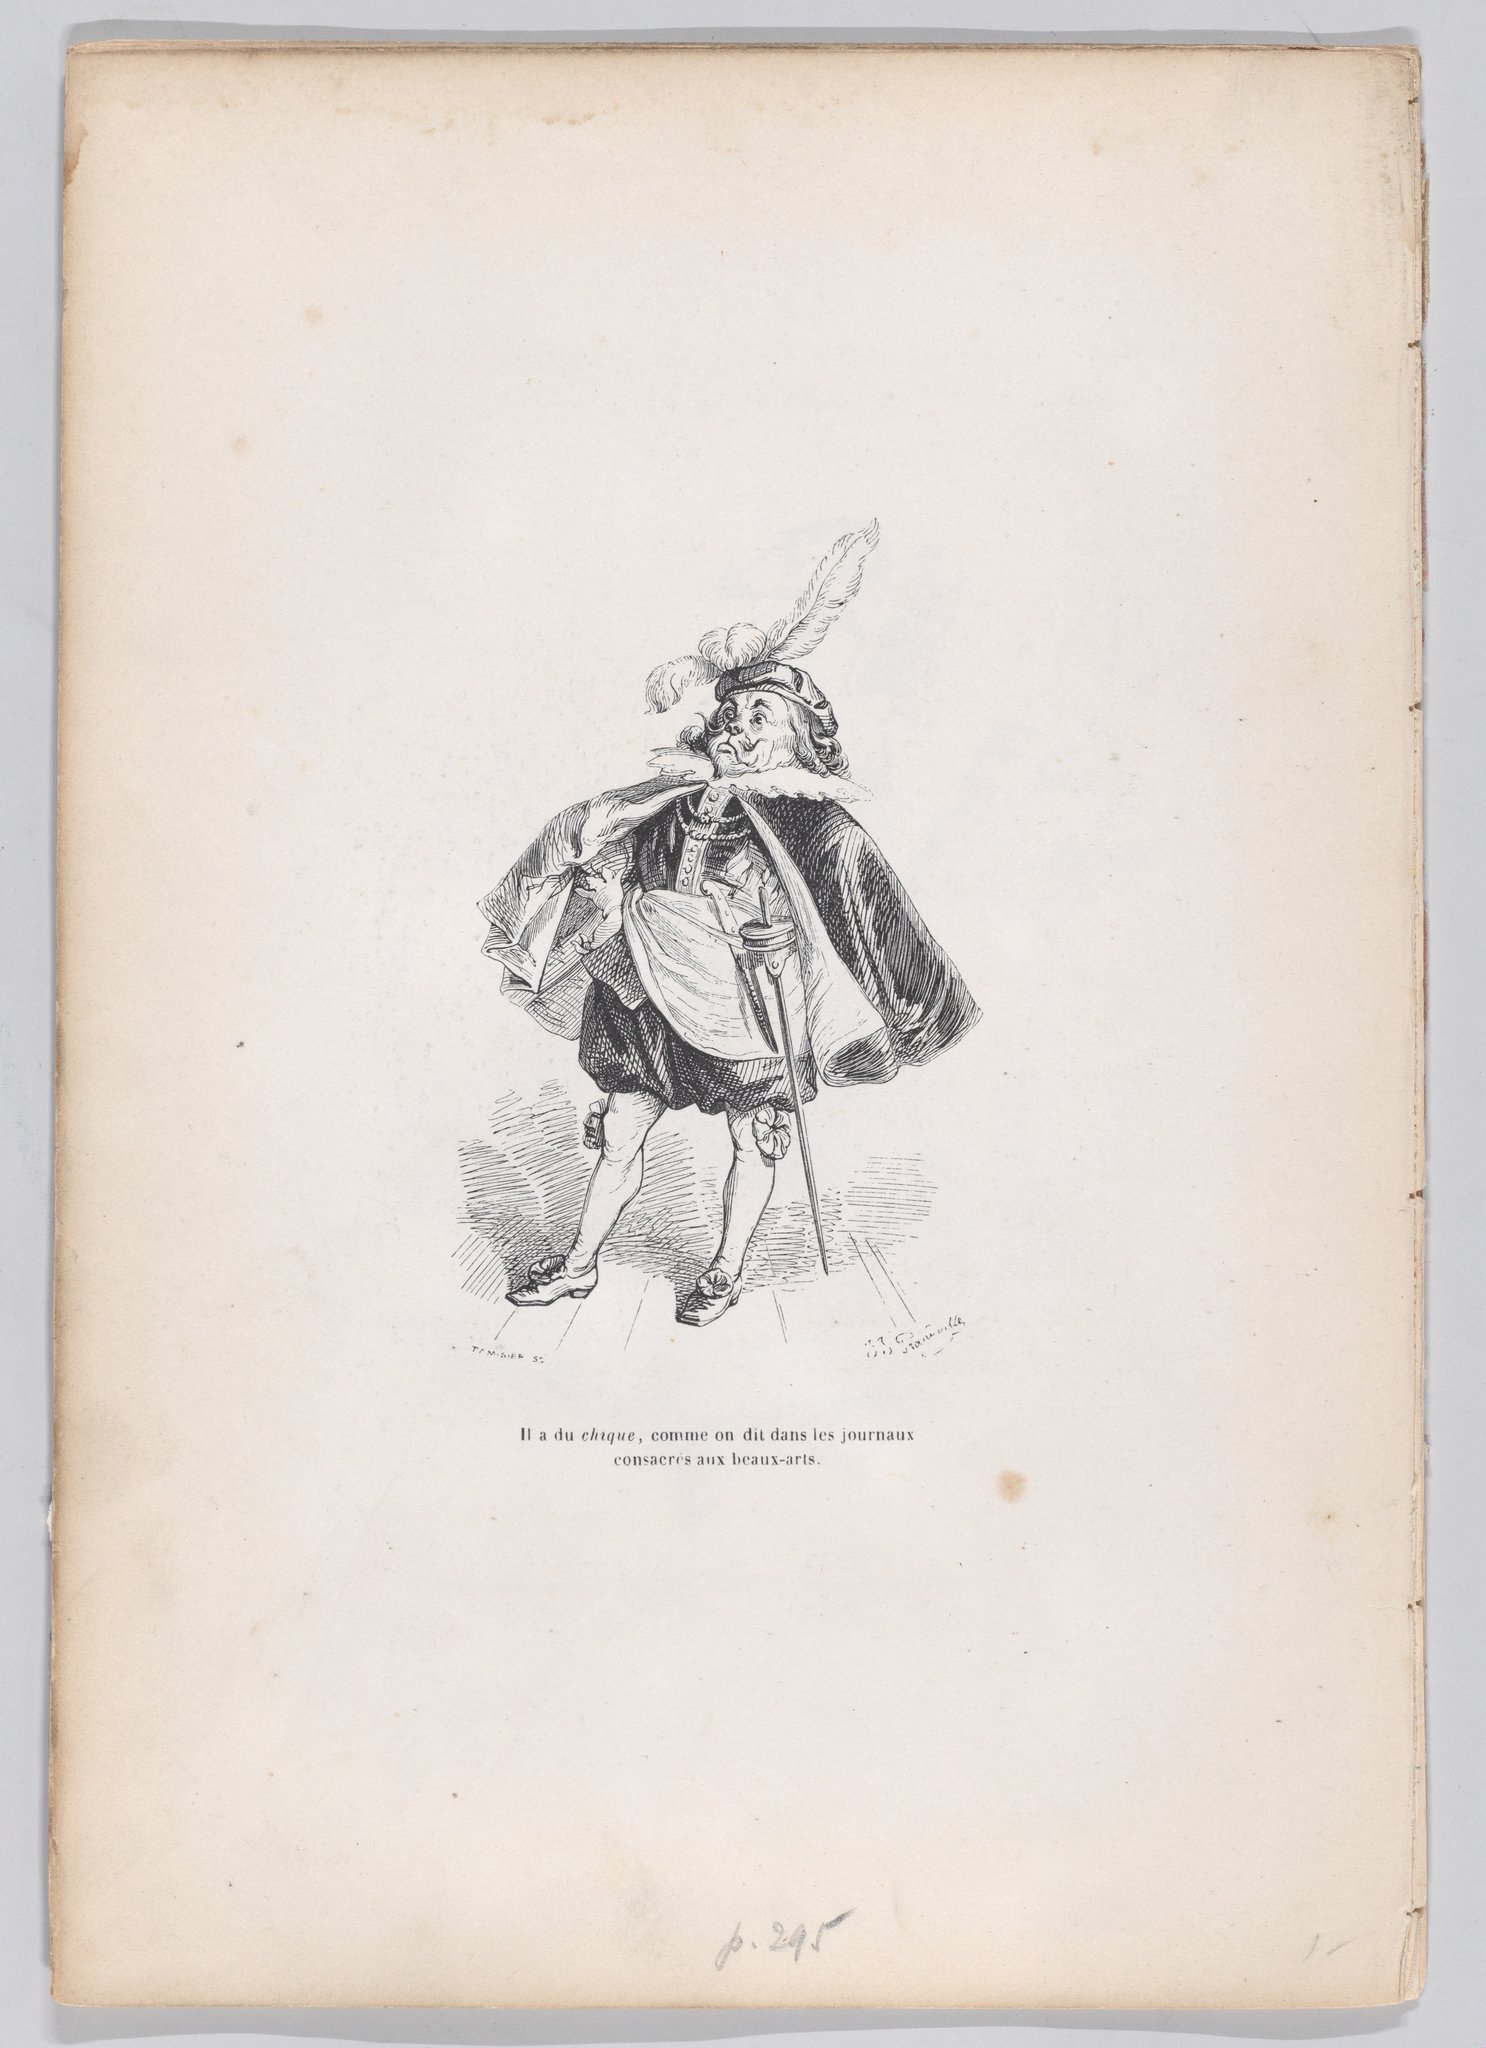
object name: print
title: He has each of them, as they say in the journals devoted to the fine arts, from "Scenes from the Private and Public Life of Animals"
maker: j. j. grandville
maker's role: illustrator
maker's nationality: french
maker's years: 1803-1847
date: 1837-1847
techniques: engraving